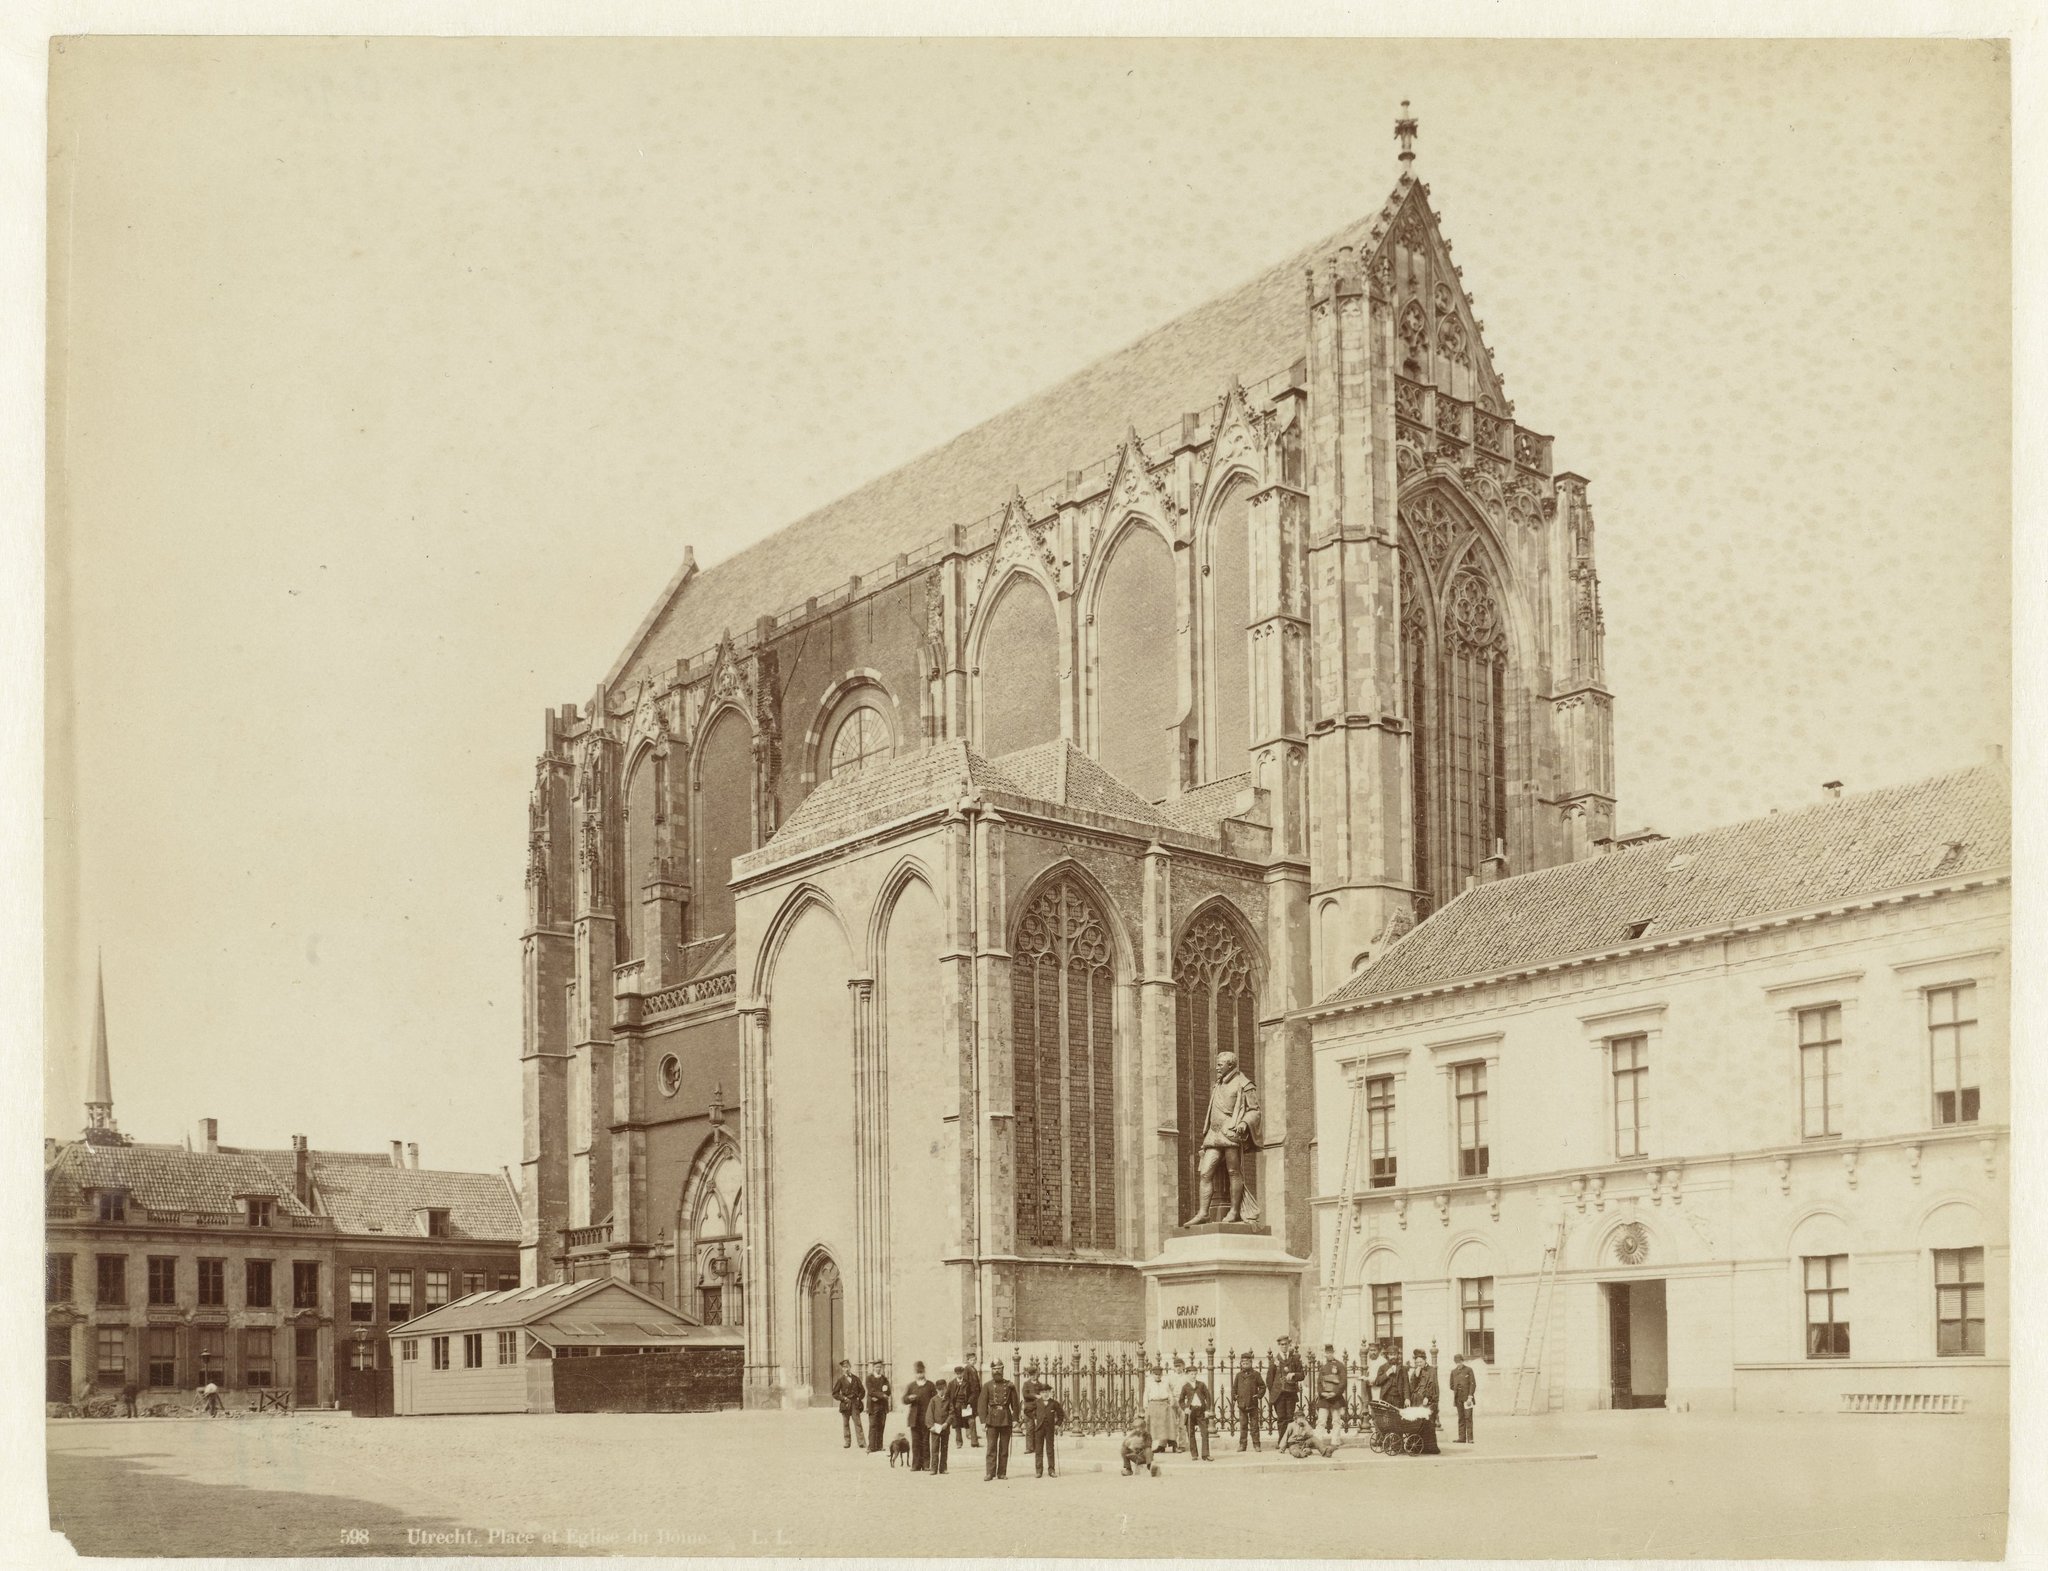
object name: photograph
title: Utrecht, Place et Eglise du Dôme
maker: Anonymous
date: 1883-1900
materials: paper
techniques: albumen print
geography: paris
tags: square, place, circus, etc., church (exterior)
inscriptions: inscription: ‘598 Utrecht, Place et Eglise du Dôme L. L’, number: ‘275’